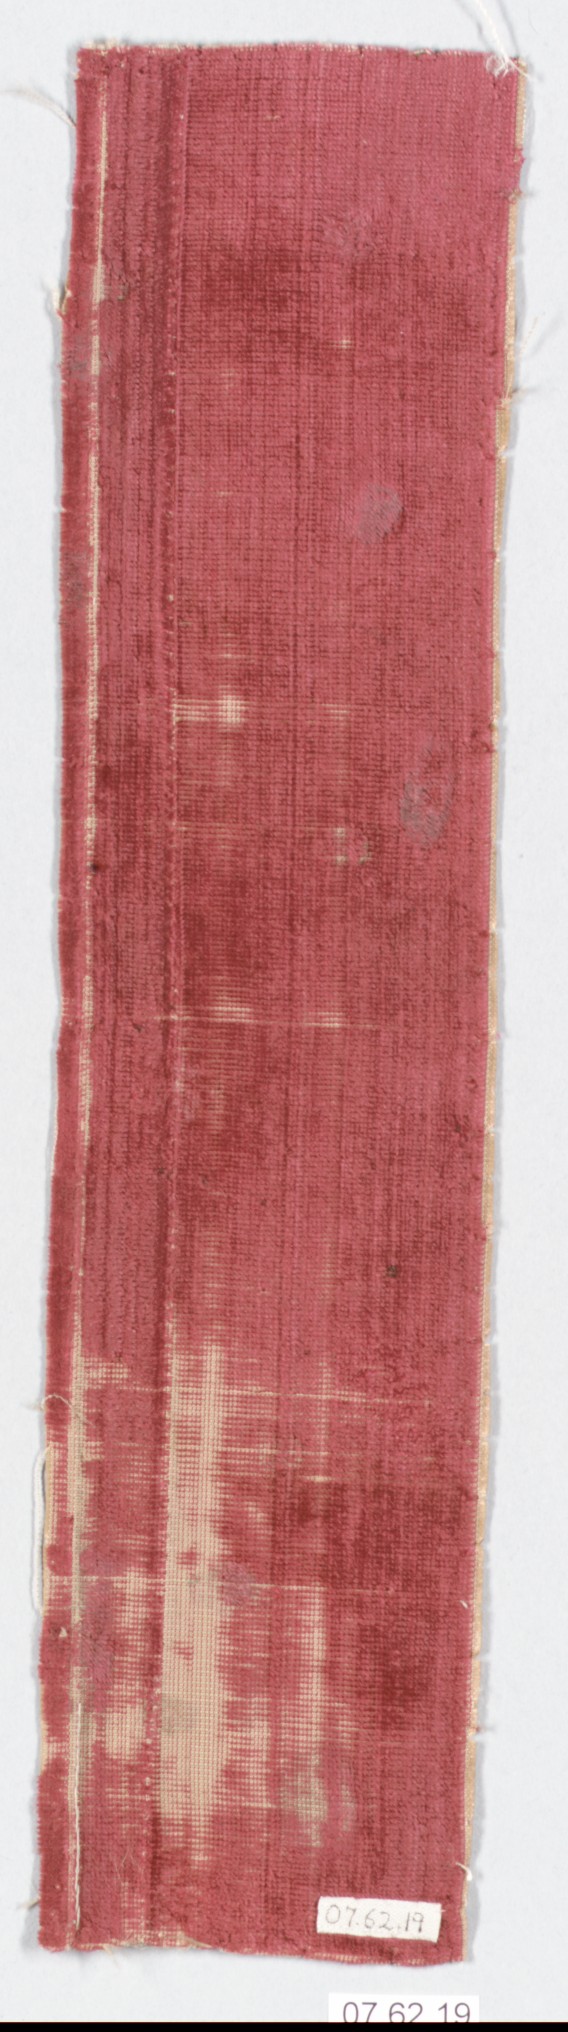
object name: piece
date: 1501-1600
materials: silk